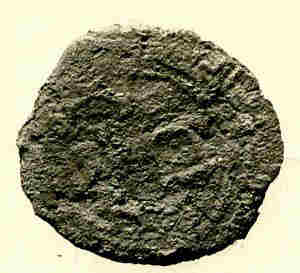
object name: coin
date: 701-900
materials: copper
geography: iran